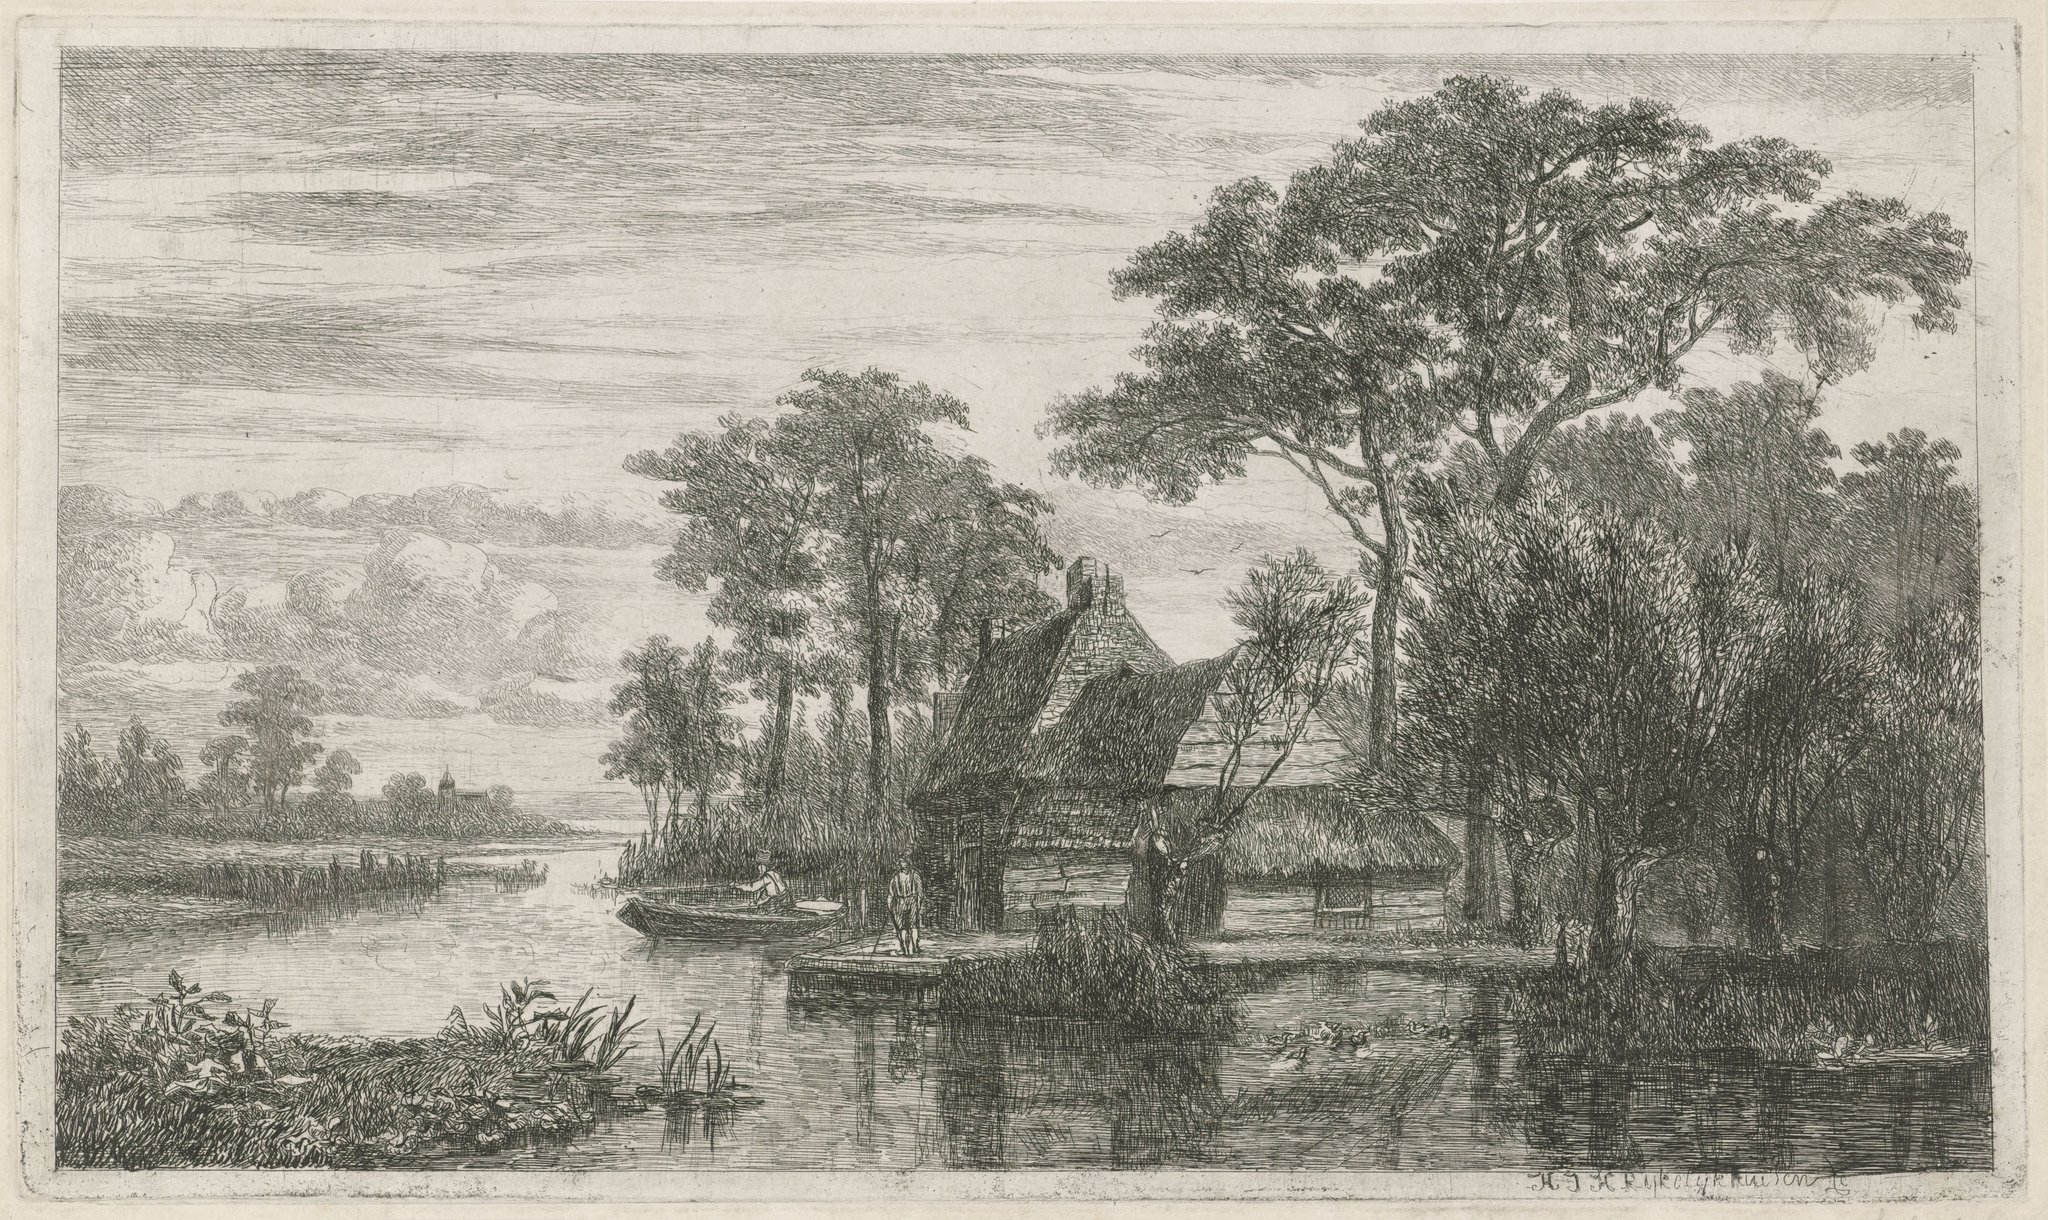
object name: print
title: Riviergezicht met hengelaars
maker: hermanus jan hendrik van rijkelijkhuysen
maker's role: painter, print maker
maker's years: 1813-1883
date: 1823-1883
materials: paper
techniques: drypoint, etching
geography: utrecht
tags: river, church (exterior), rowing-boat, canoe, etc., trees: willow, farm or solitary house in landscape, water-birds: duck, fisherman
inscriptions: collector's mark: Lugt 2228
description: Een rivier met aan de waterkant enige huizen en twee hengelaars. Op de voorgrond een groep eenden en twee knotwilgen. Op de achtergrond de contouren van een kerk.